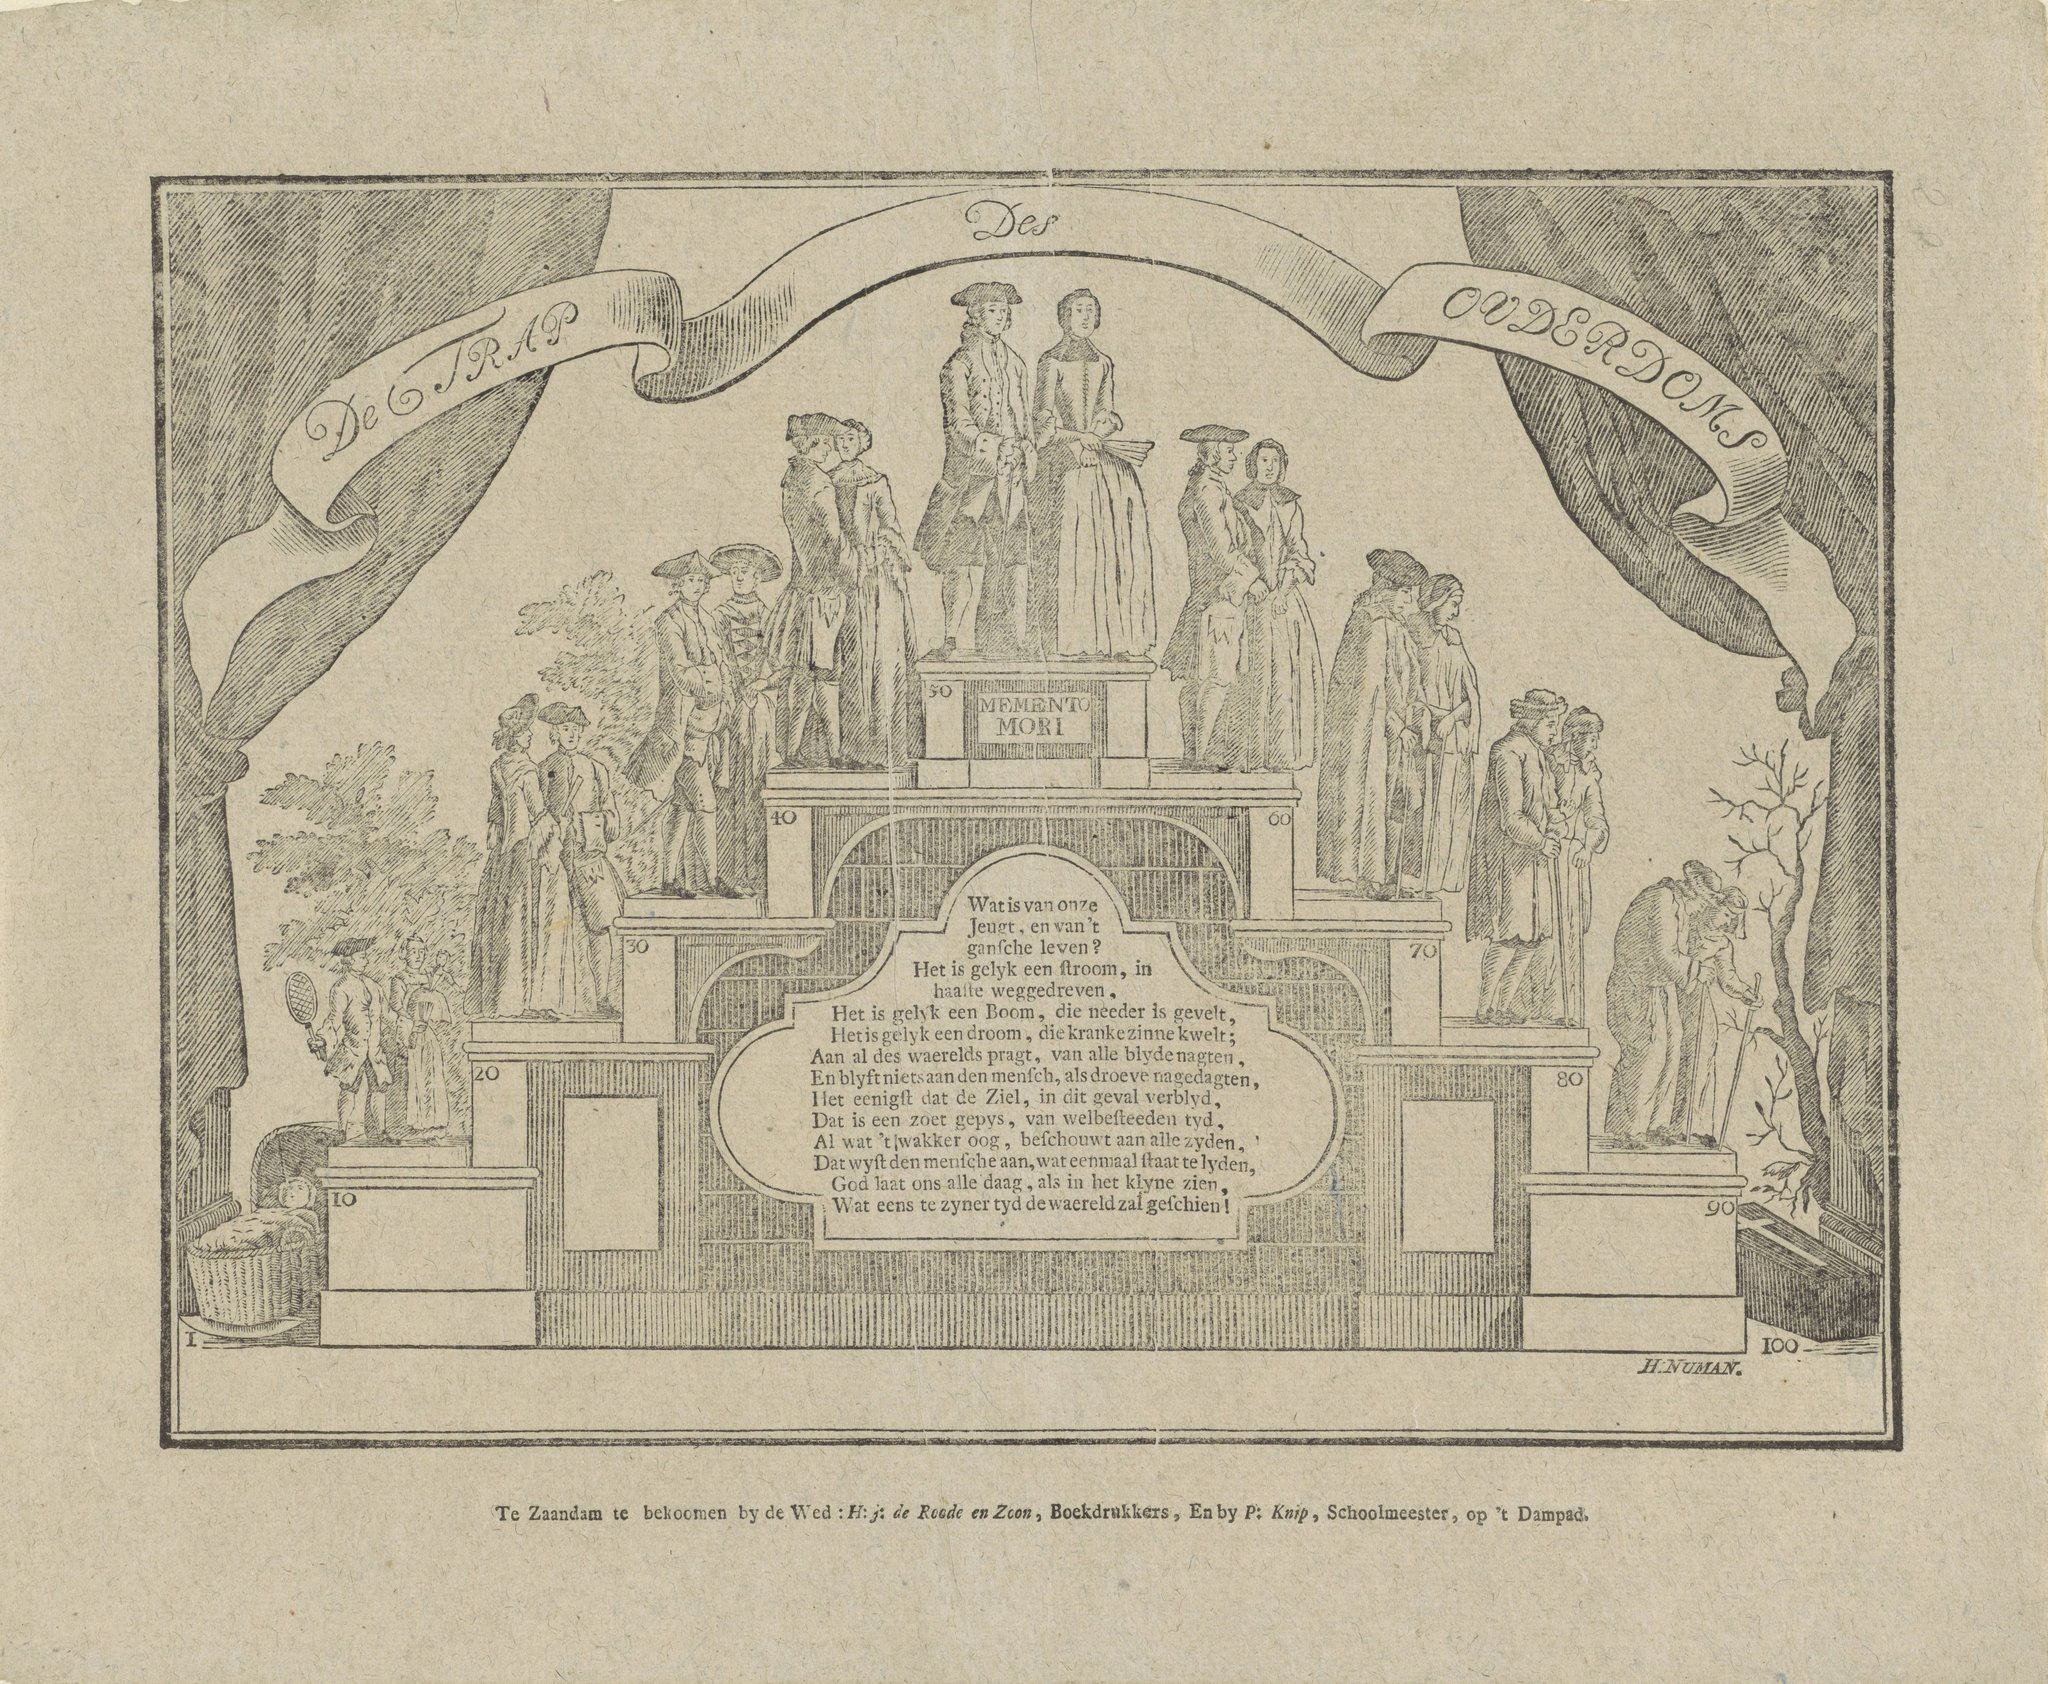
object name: print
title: De trap des ouderdoms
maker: pieter knip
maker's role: publisher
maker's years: 1746-1808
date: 1792-1803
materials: paper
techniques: letterpress printing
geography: zaandam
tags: the ages of man represented by a staircase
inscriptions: collector's mark: Lugt 2760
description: Een trap des ouderdoms: een parentrap. Op de treden van de trap, in de vorm van een brug, staan mennen en vrouwen in de leeftijd van 0 tot 100 jaar. Onder de brug een cartouche met tekst. Aan weerszijden van de voorstelling een gordijn.